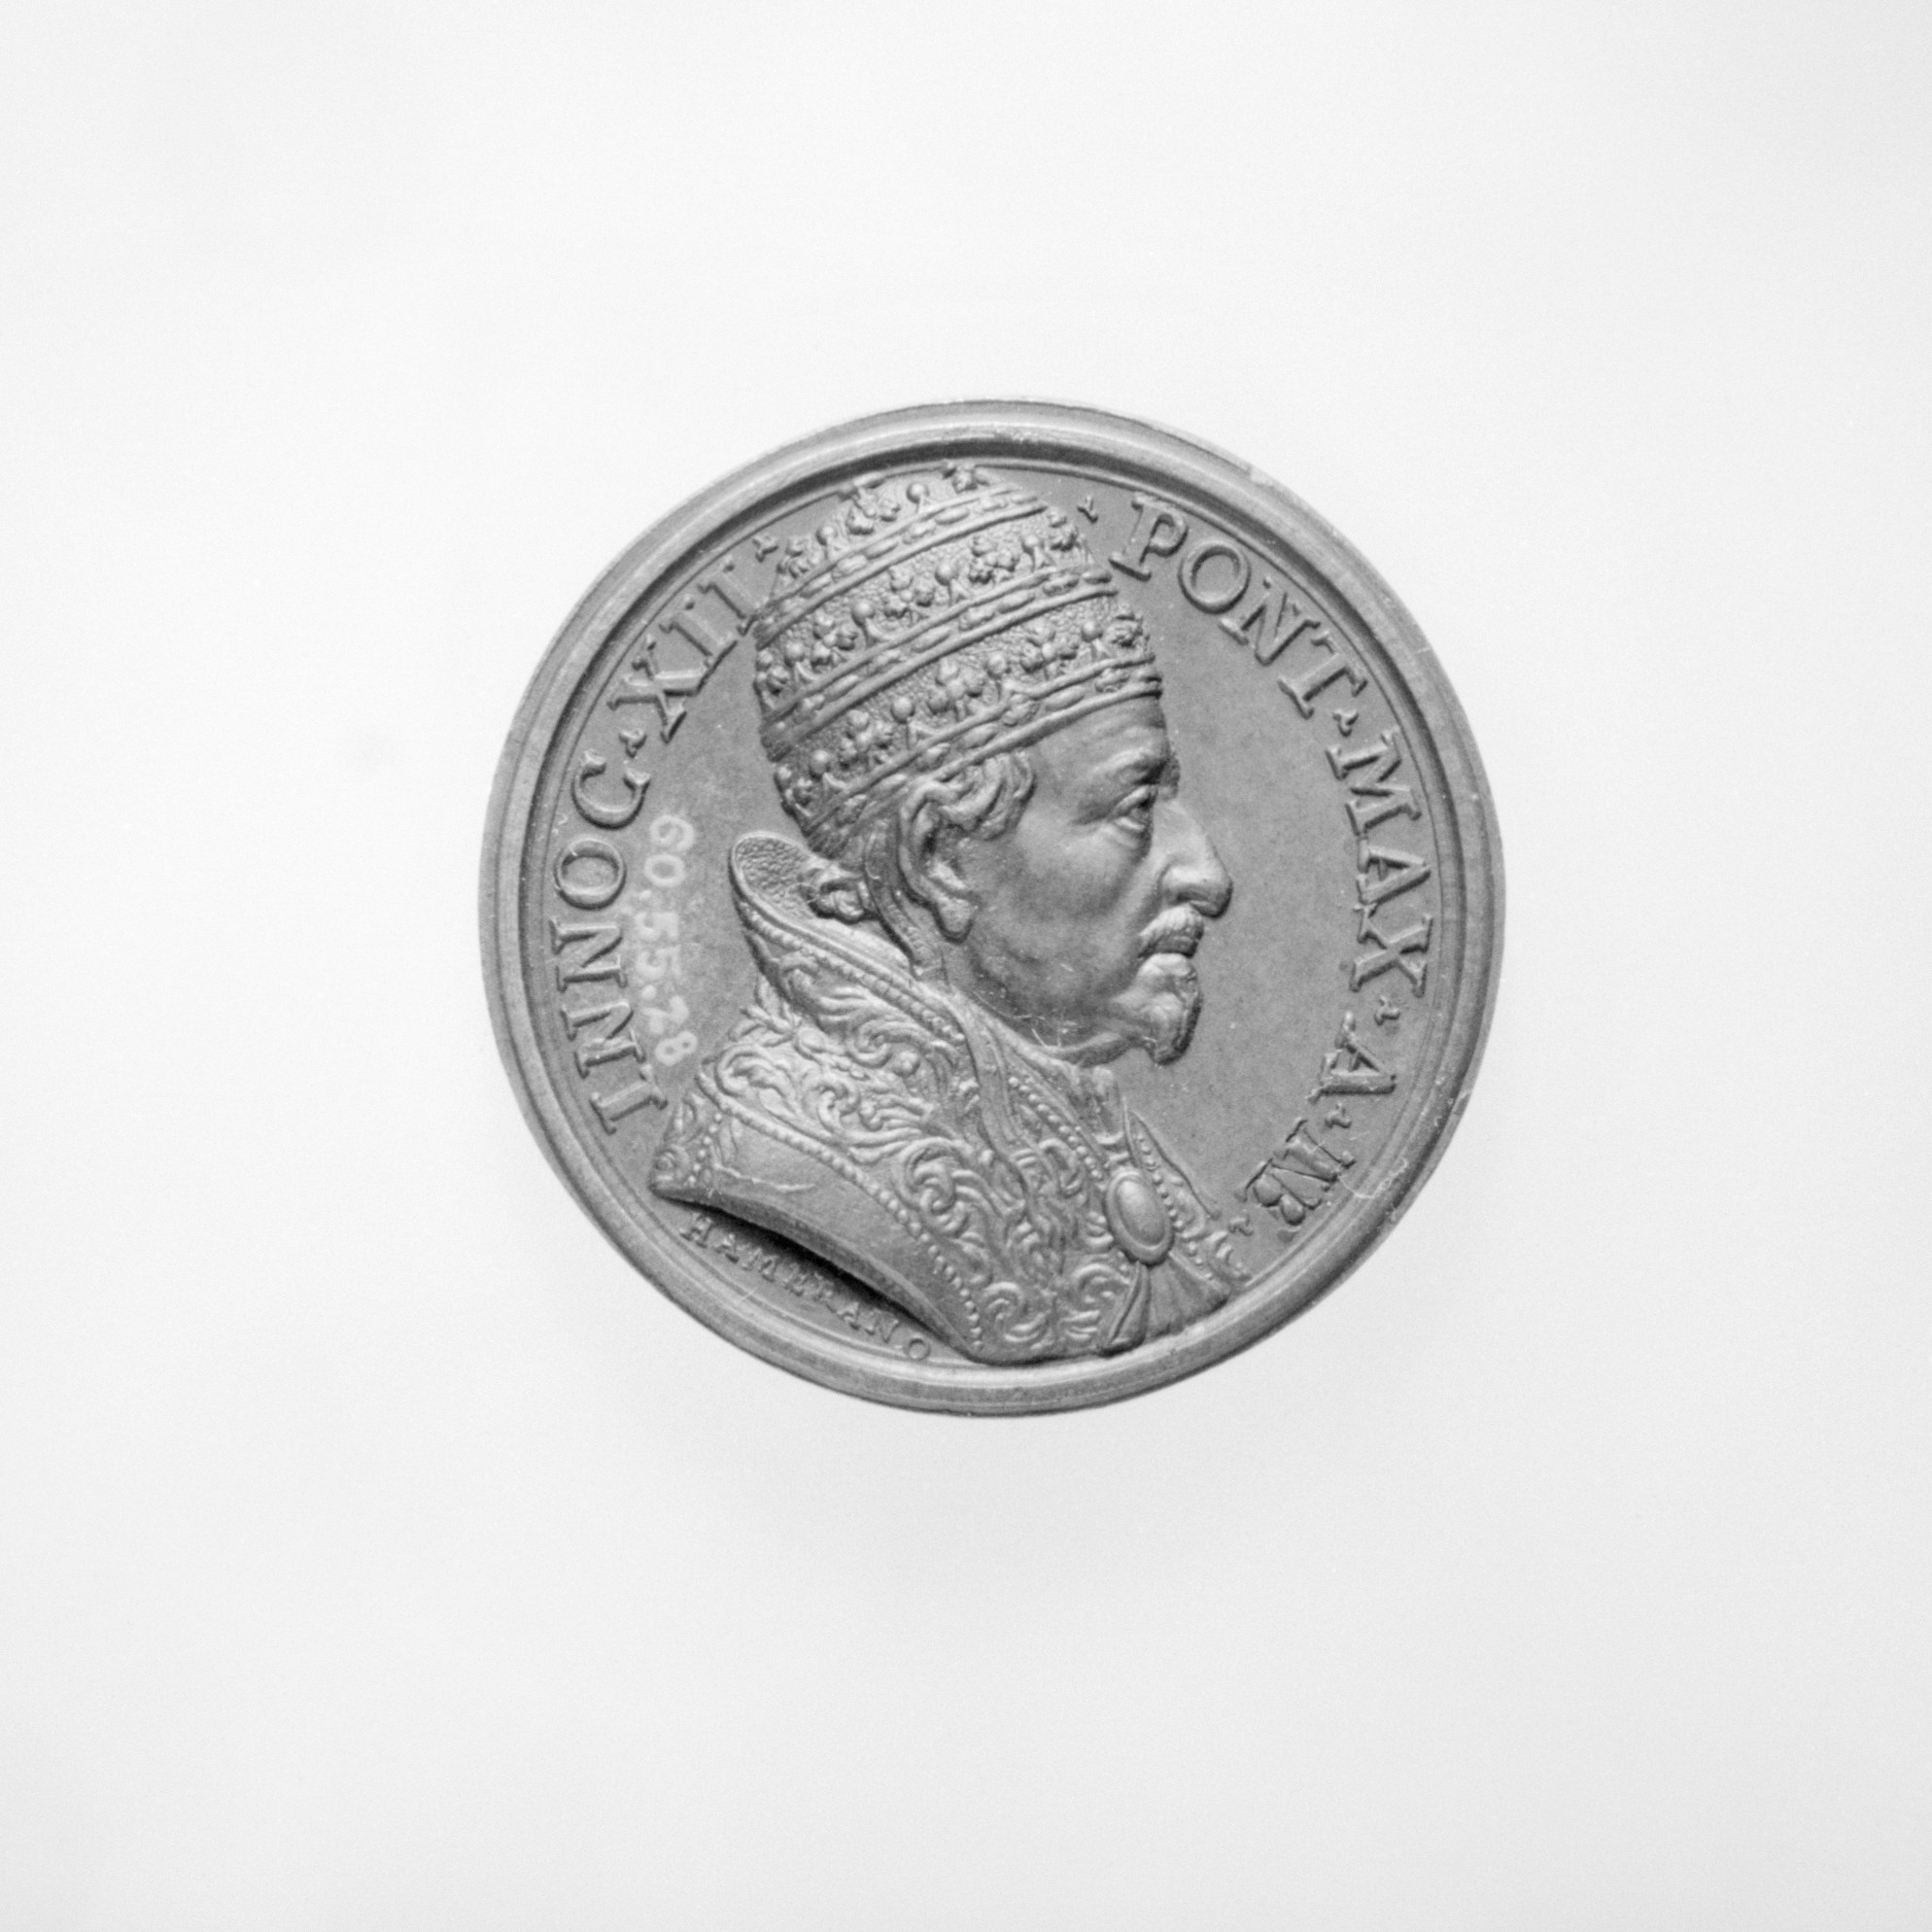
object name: medal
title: Innocent XII (Pope, 1691–1700)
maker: giovanni martino hamerani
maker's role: artist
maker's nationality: italian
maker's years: 1646-1705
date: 1601-1700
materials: bronze, patina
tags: men,profiles,popes